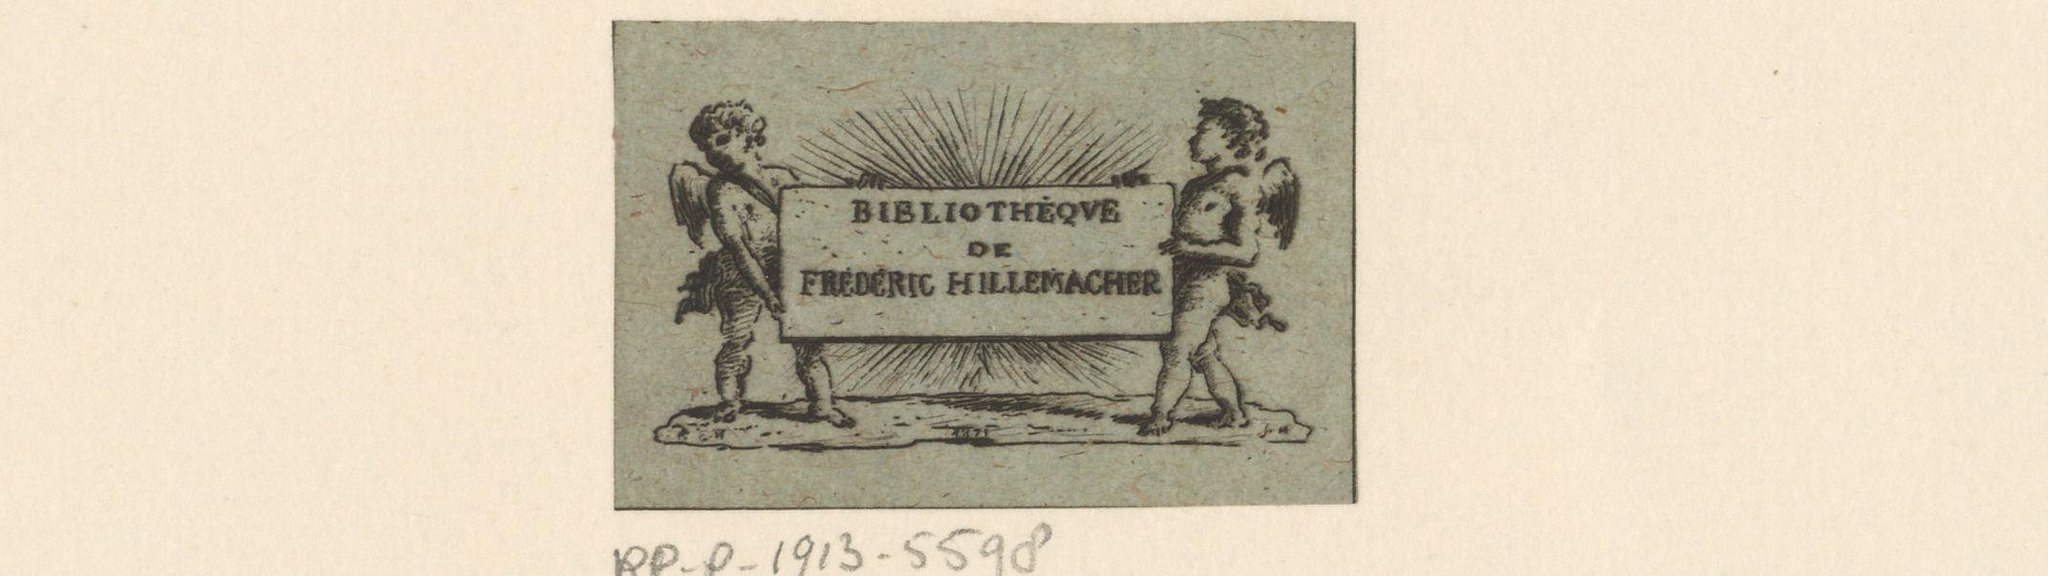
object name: bookplate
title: Ex libris van Frédéric-Désiré Hillemacher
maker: Anonymous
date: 1871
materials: paper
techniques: etching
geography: france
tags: paris, frédéric-désiré hillemacher, cupids: 'amores', 'amoretti', 'putti'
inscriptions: collector's mark: Lugt 2233, collector's mark: Lugt 2760